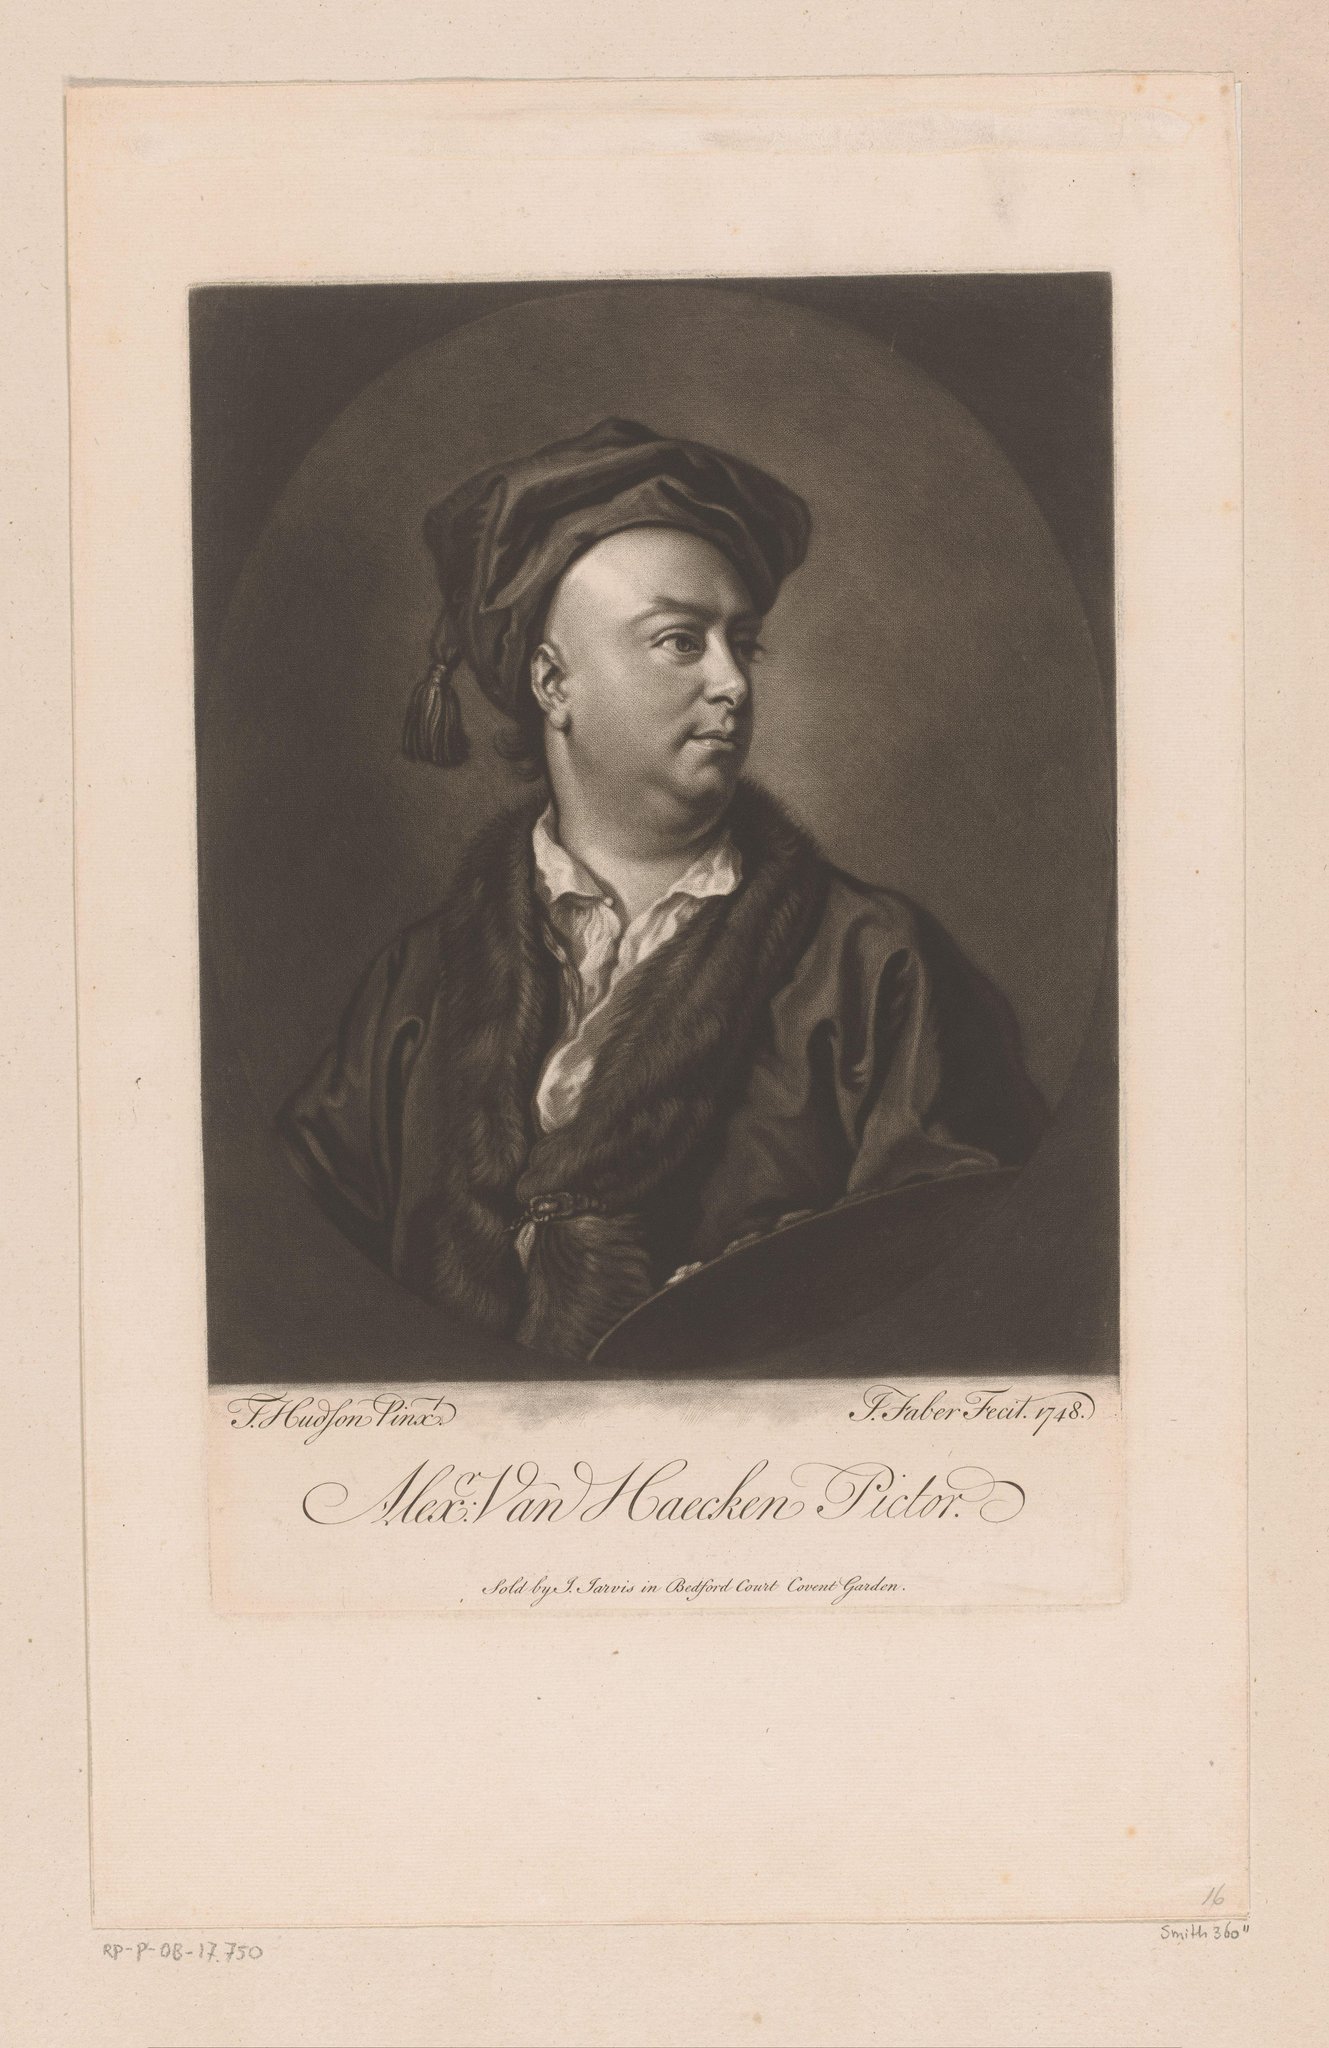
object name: print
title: Portret van Alexander van Haecken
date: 1748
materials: paper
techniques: etching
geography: london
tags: antwerp, london, painter, print maker, alexander van haecken, historical persons, portrait, self-portrait of painter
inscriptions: collector's mark: Lugt 240